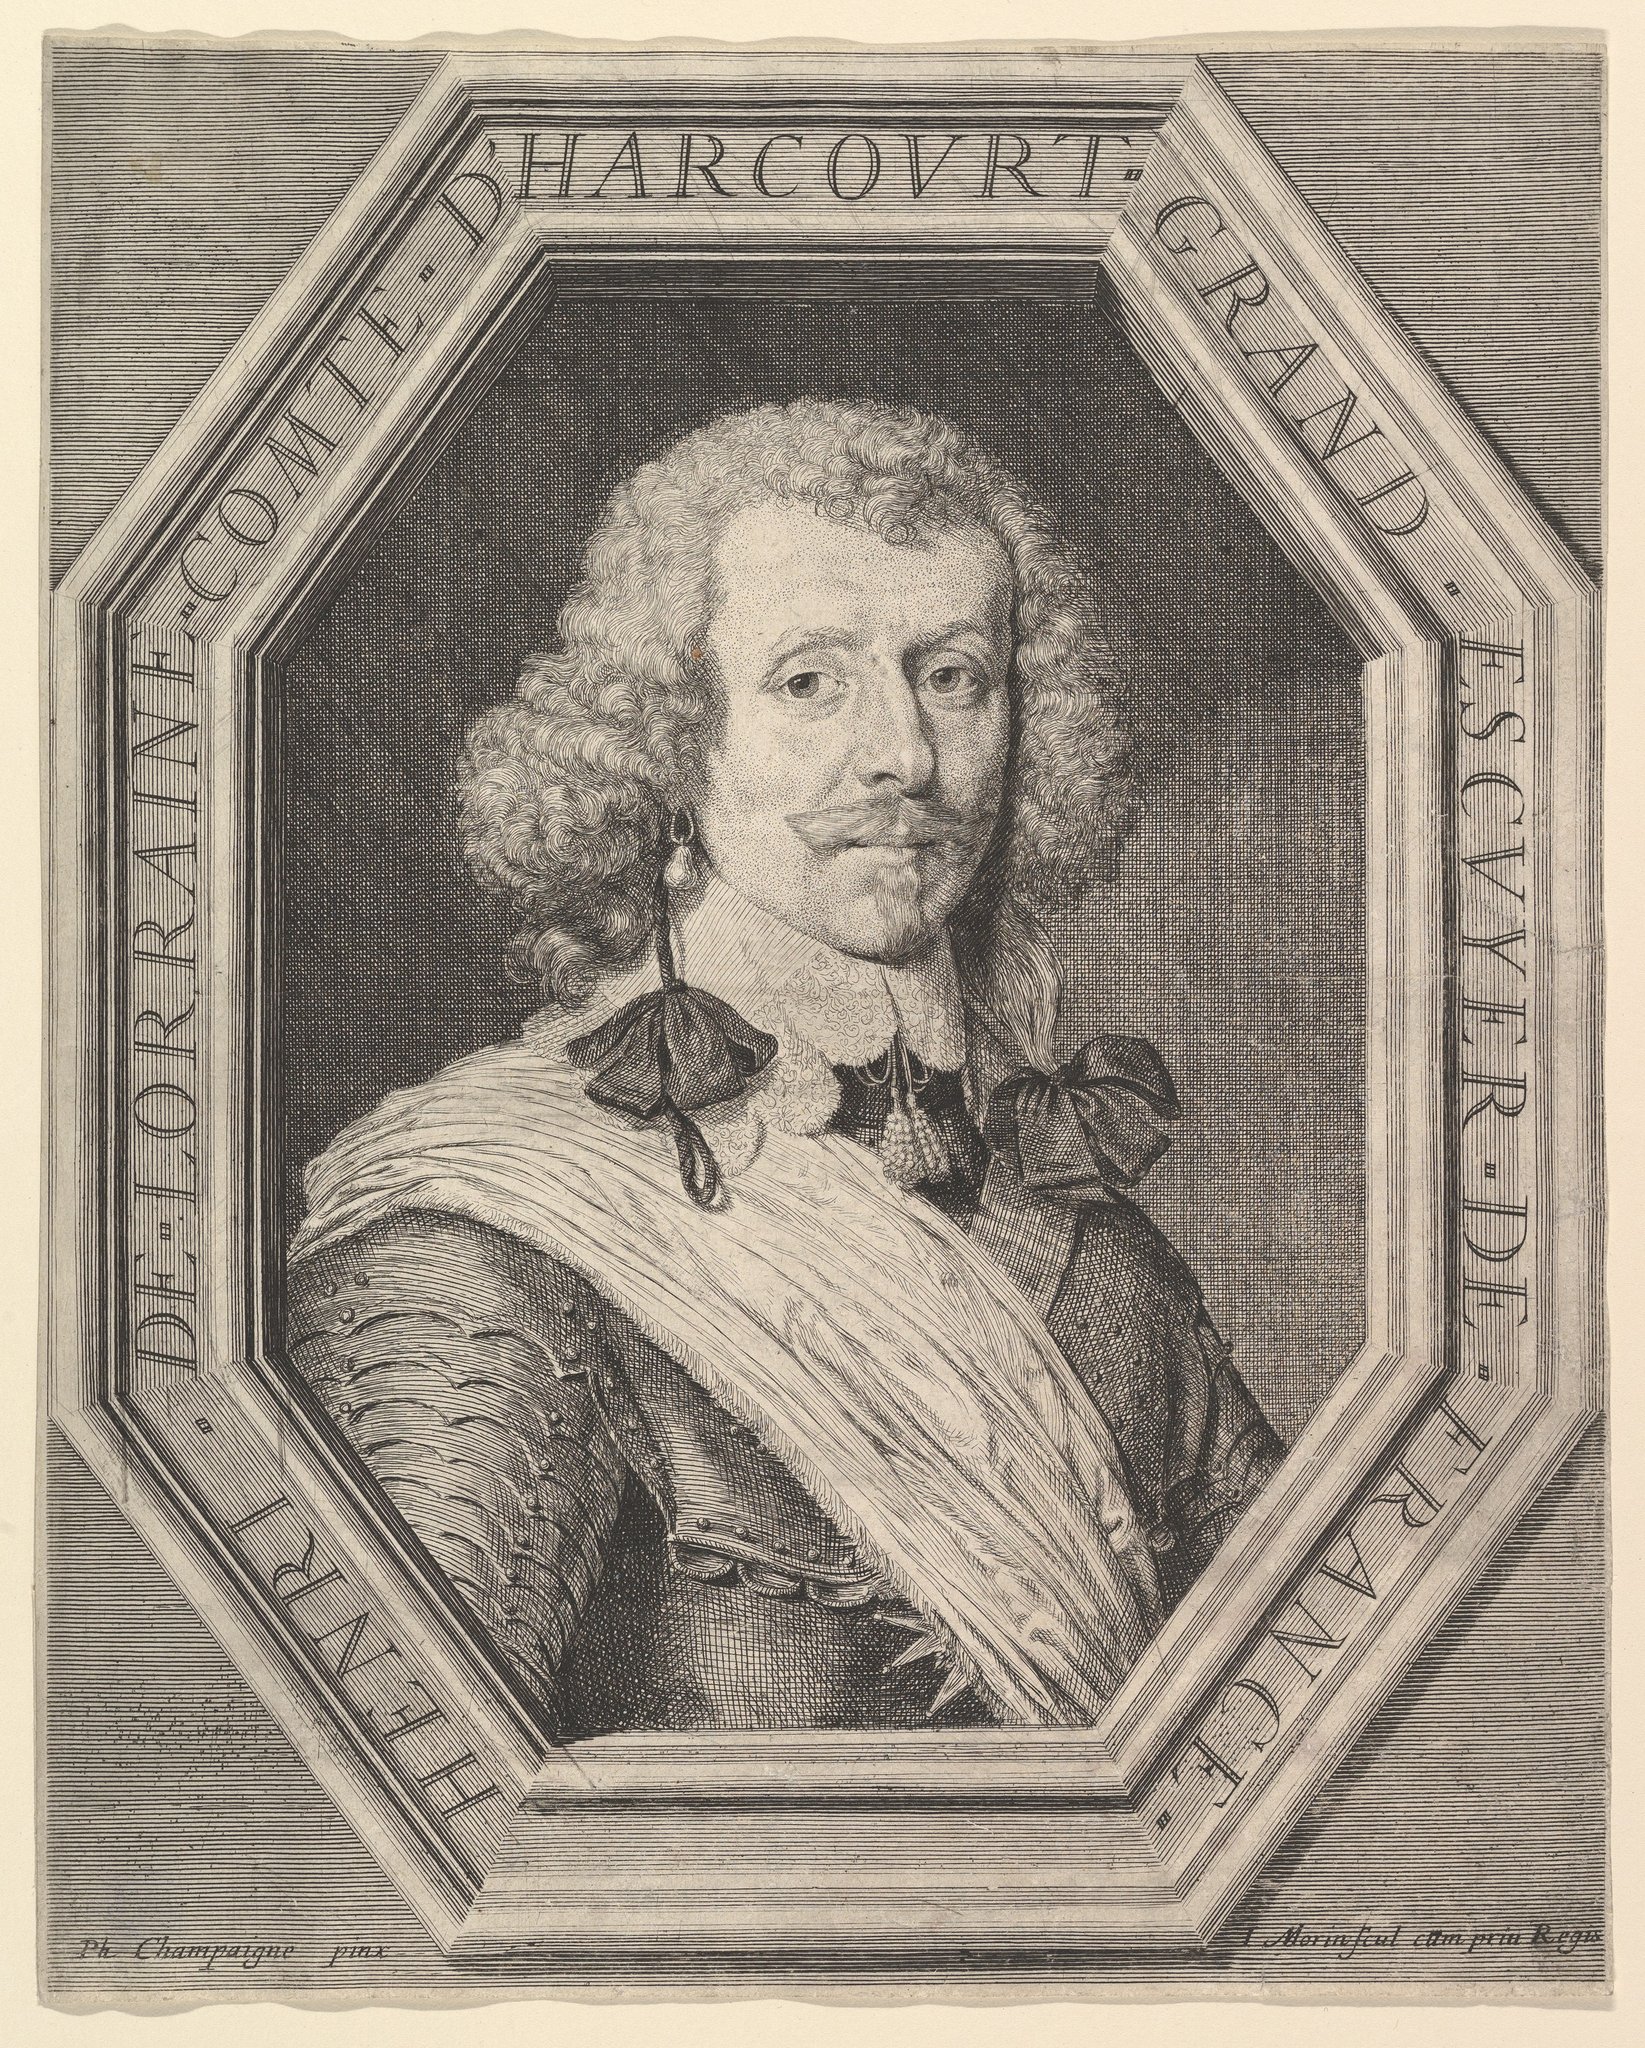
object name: print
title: Henri de Lorraine, comte d'Harcourt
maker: jean morin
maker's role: artist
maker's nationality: french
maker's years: 1605-1650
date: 1605-1650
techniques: etching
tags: men,portraits